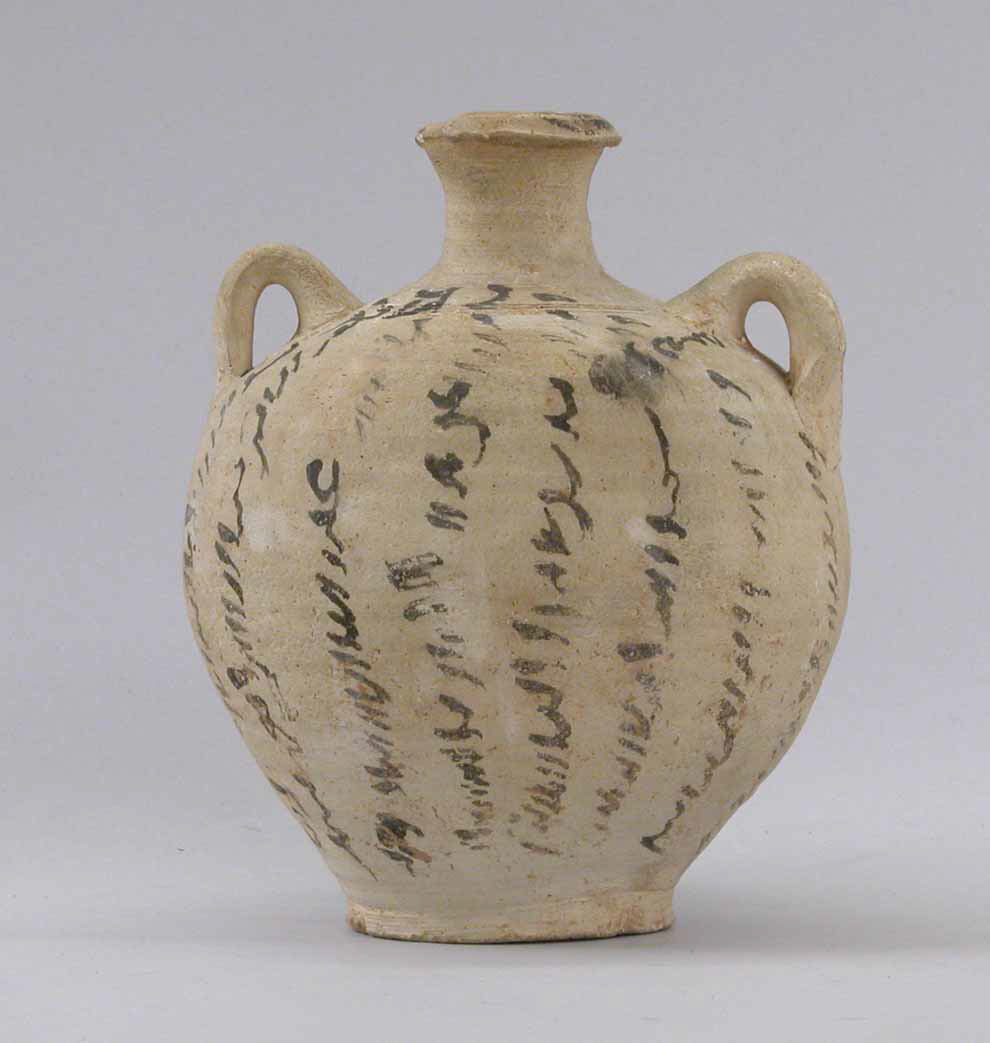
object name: jar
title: Jar with Writing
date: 701-1000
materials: earthenware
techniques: painting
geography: iran